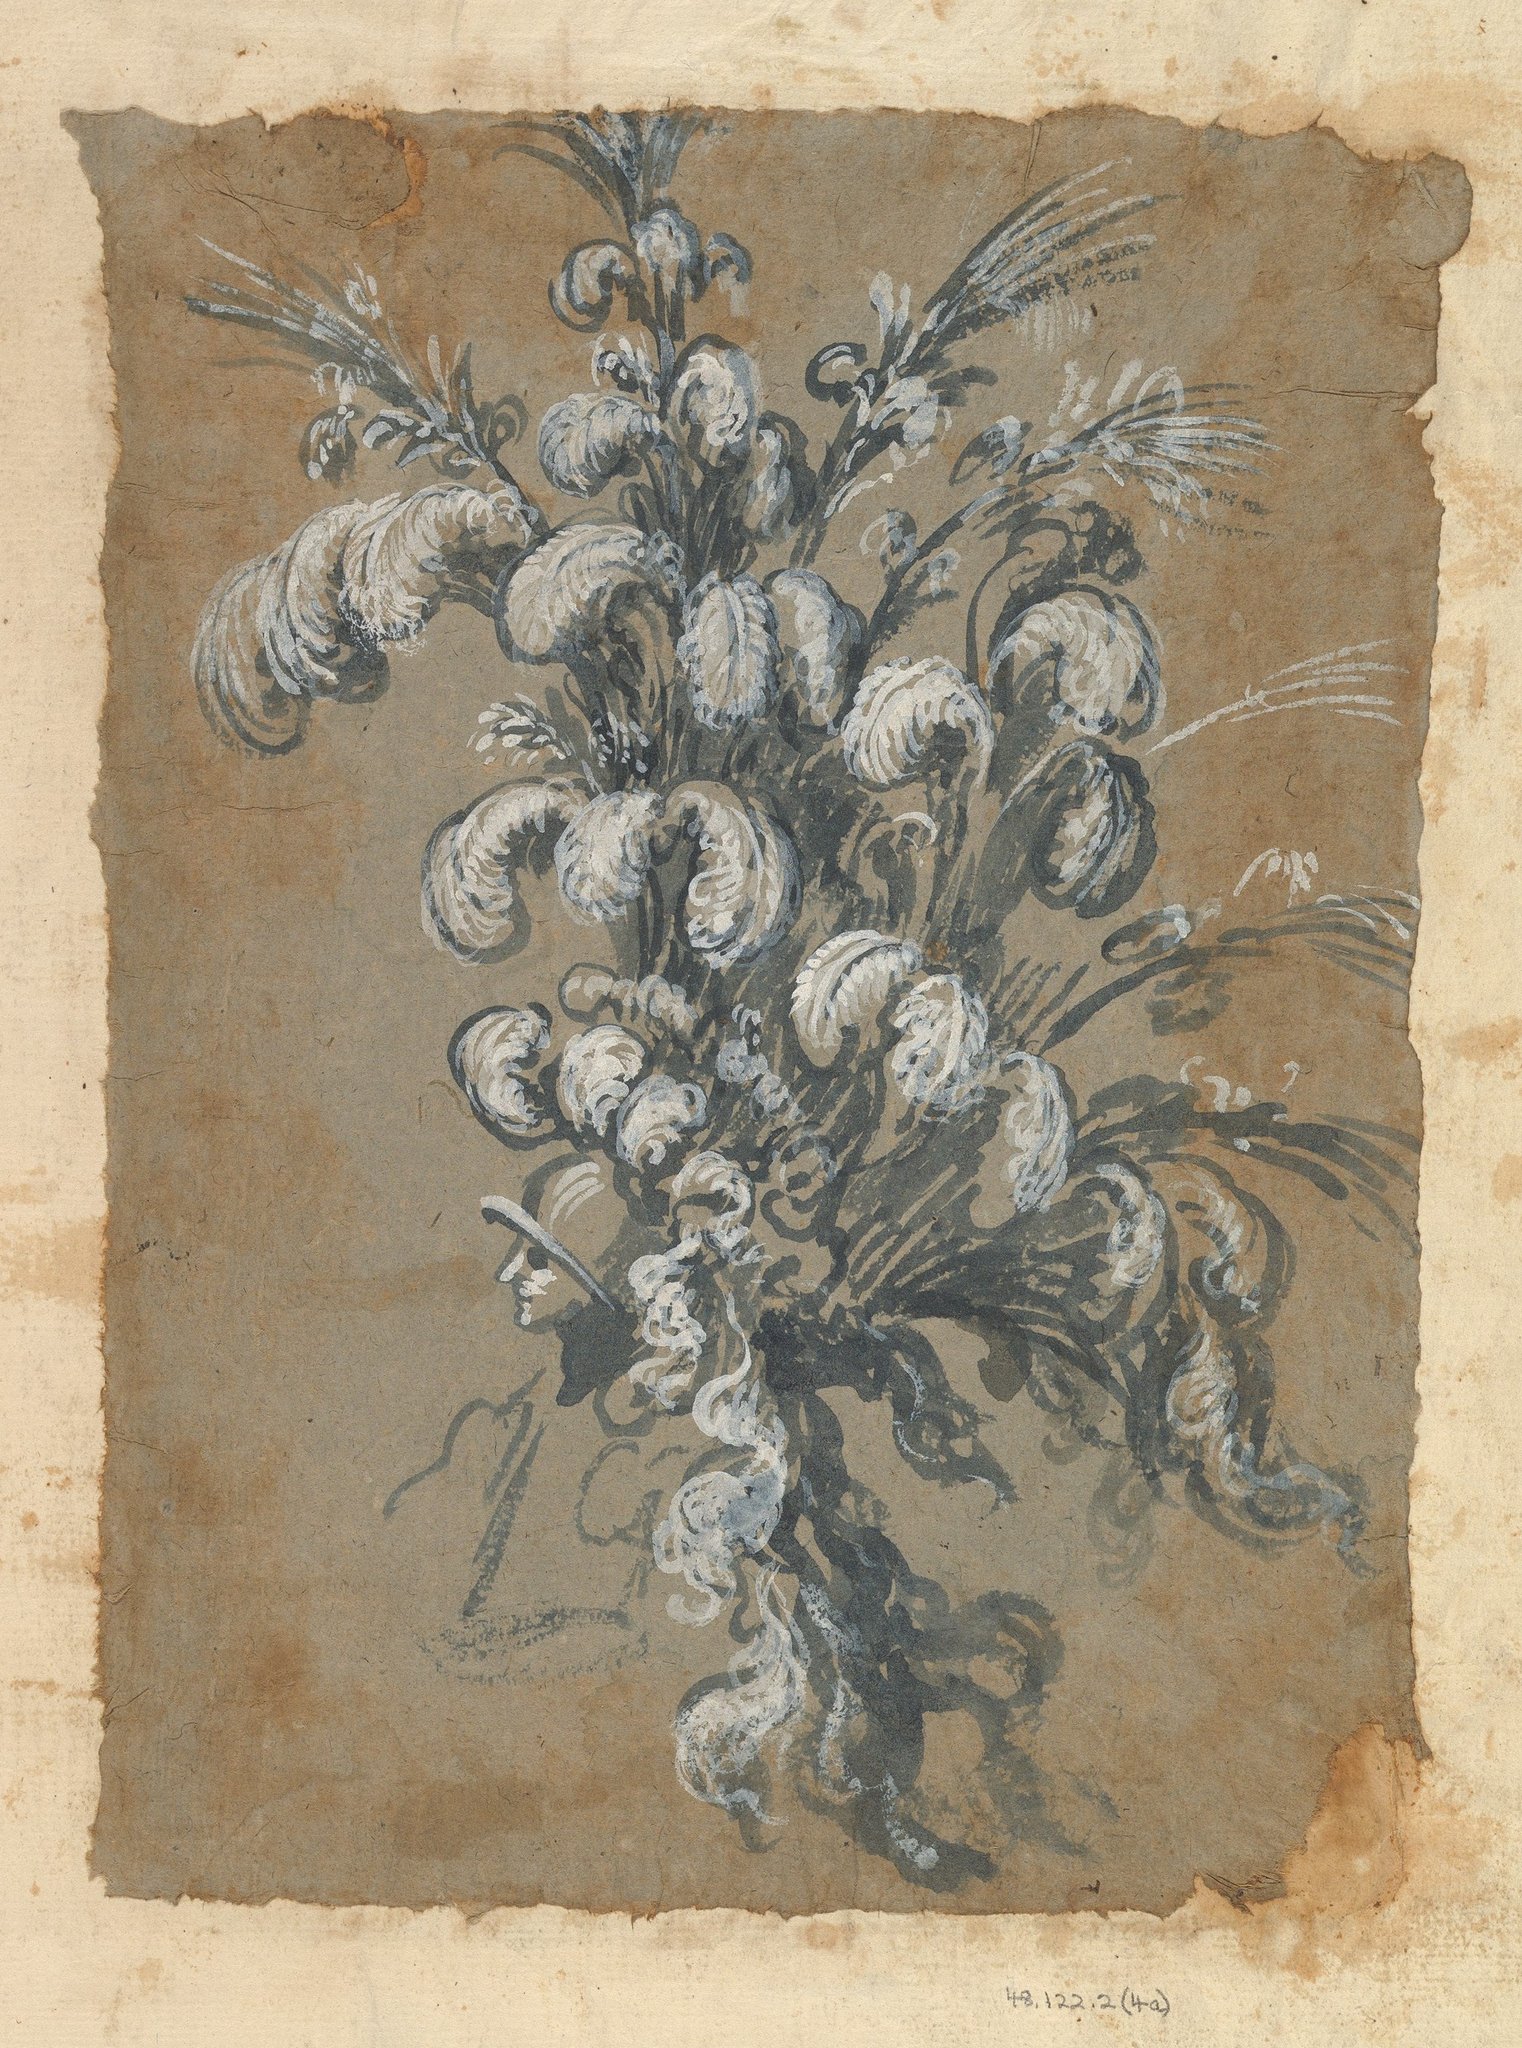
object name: collection ornament architecture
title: Design for a Lavish Headdress with Feathers on a Helmet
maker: baccio del bianco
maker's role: artist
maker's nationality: italian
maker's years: 1604-1656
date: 1620-1656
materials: gouache, watercolor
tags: feathers,headdresses